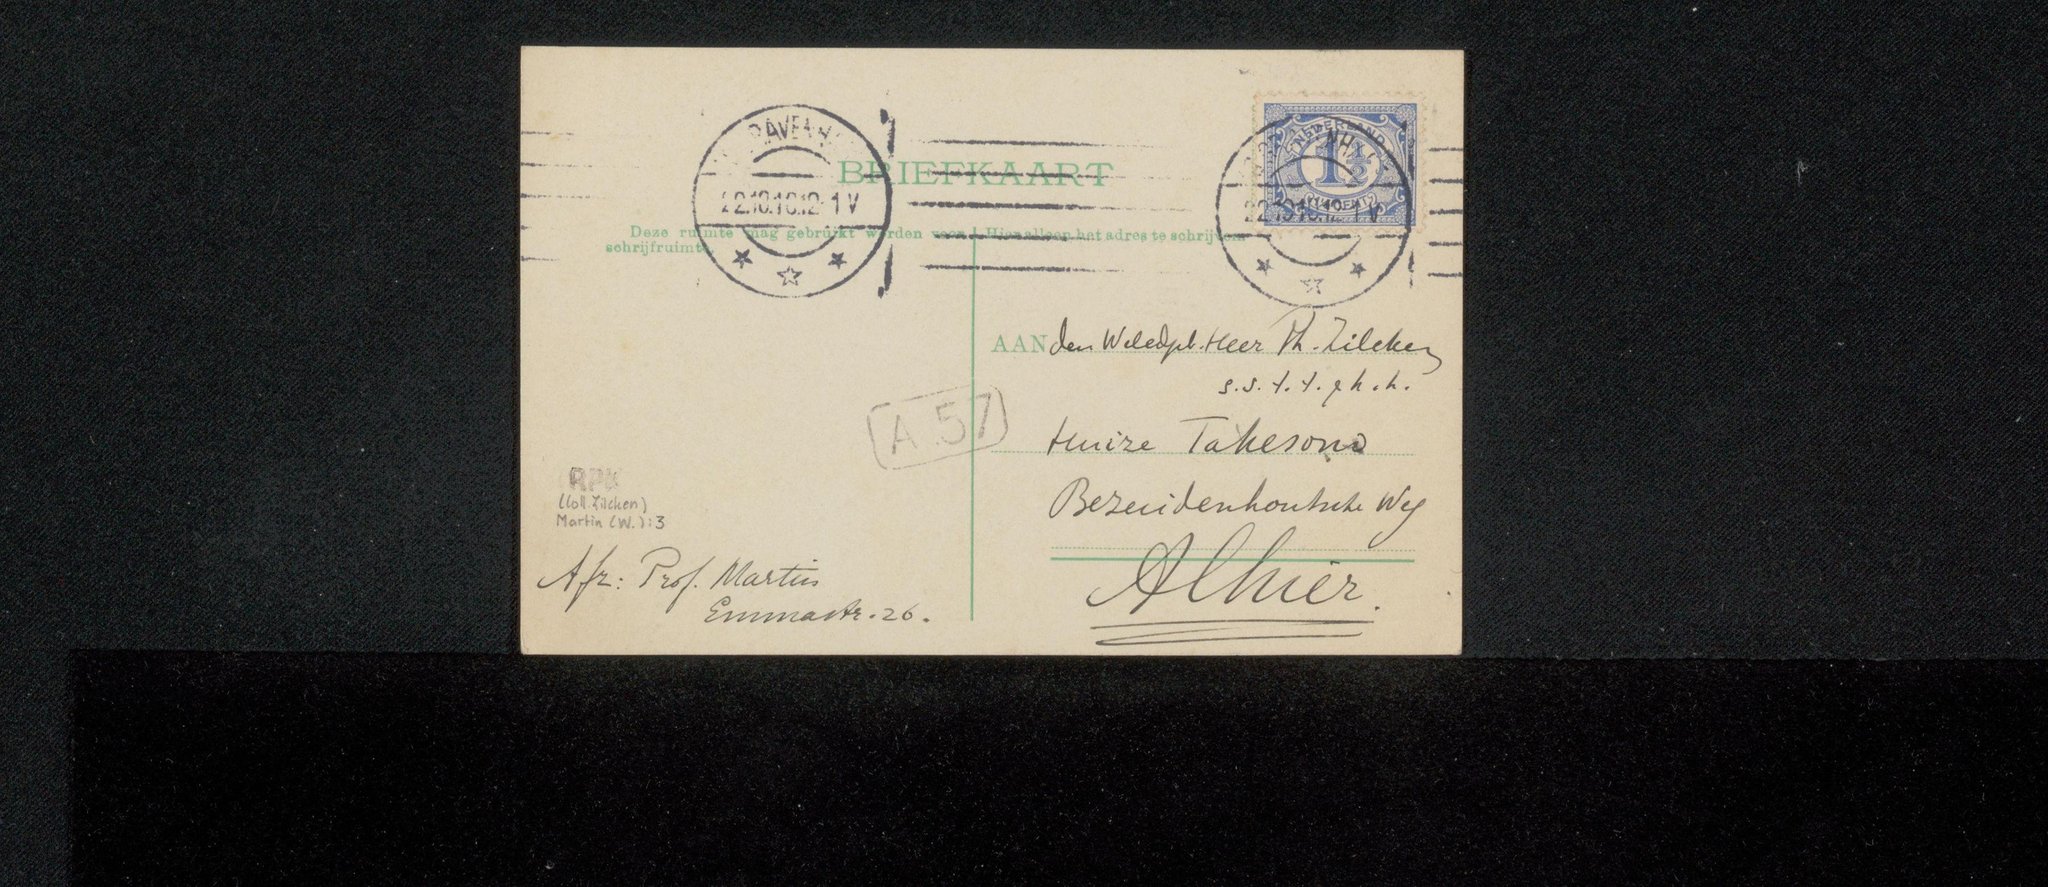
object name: postcard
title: Briefkaart aan Philip Zilcken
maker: wilhelm martin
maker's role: draughtsman, painter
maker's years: 1876-1954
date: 1910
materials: cardboard, ink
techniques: pen, writing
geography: the hague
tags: print maker, jozef israëls, johan rudolf thorbecke, philip zilcken, the graphic arts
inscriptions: collector's mark: ‘RPK’